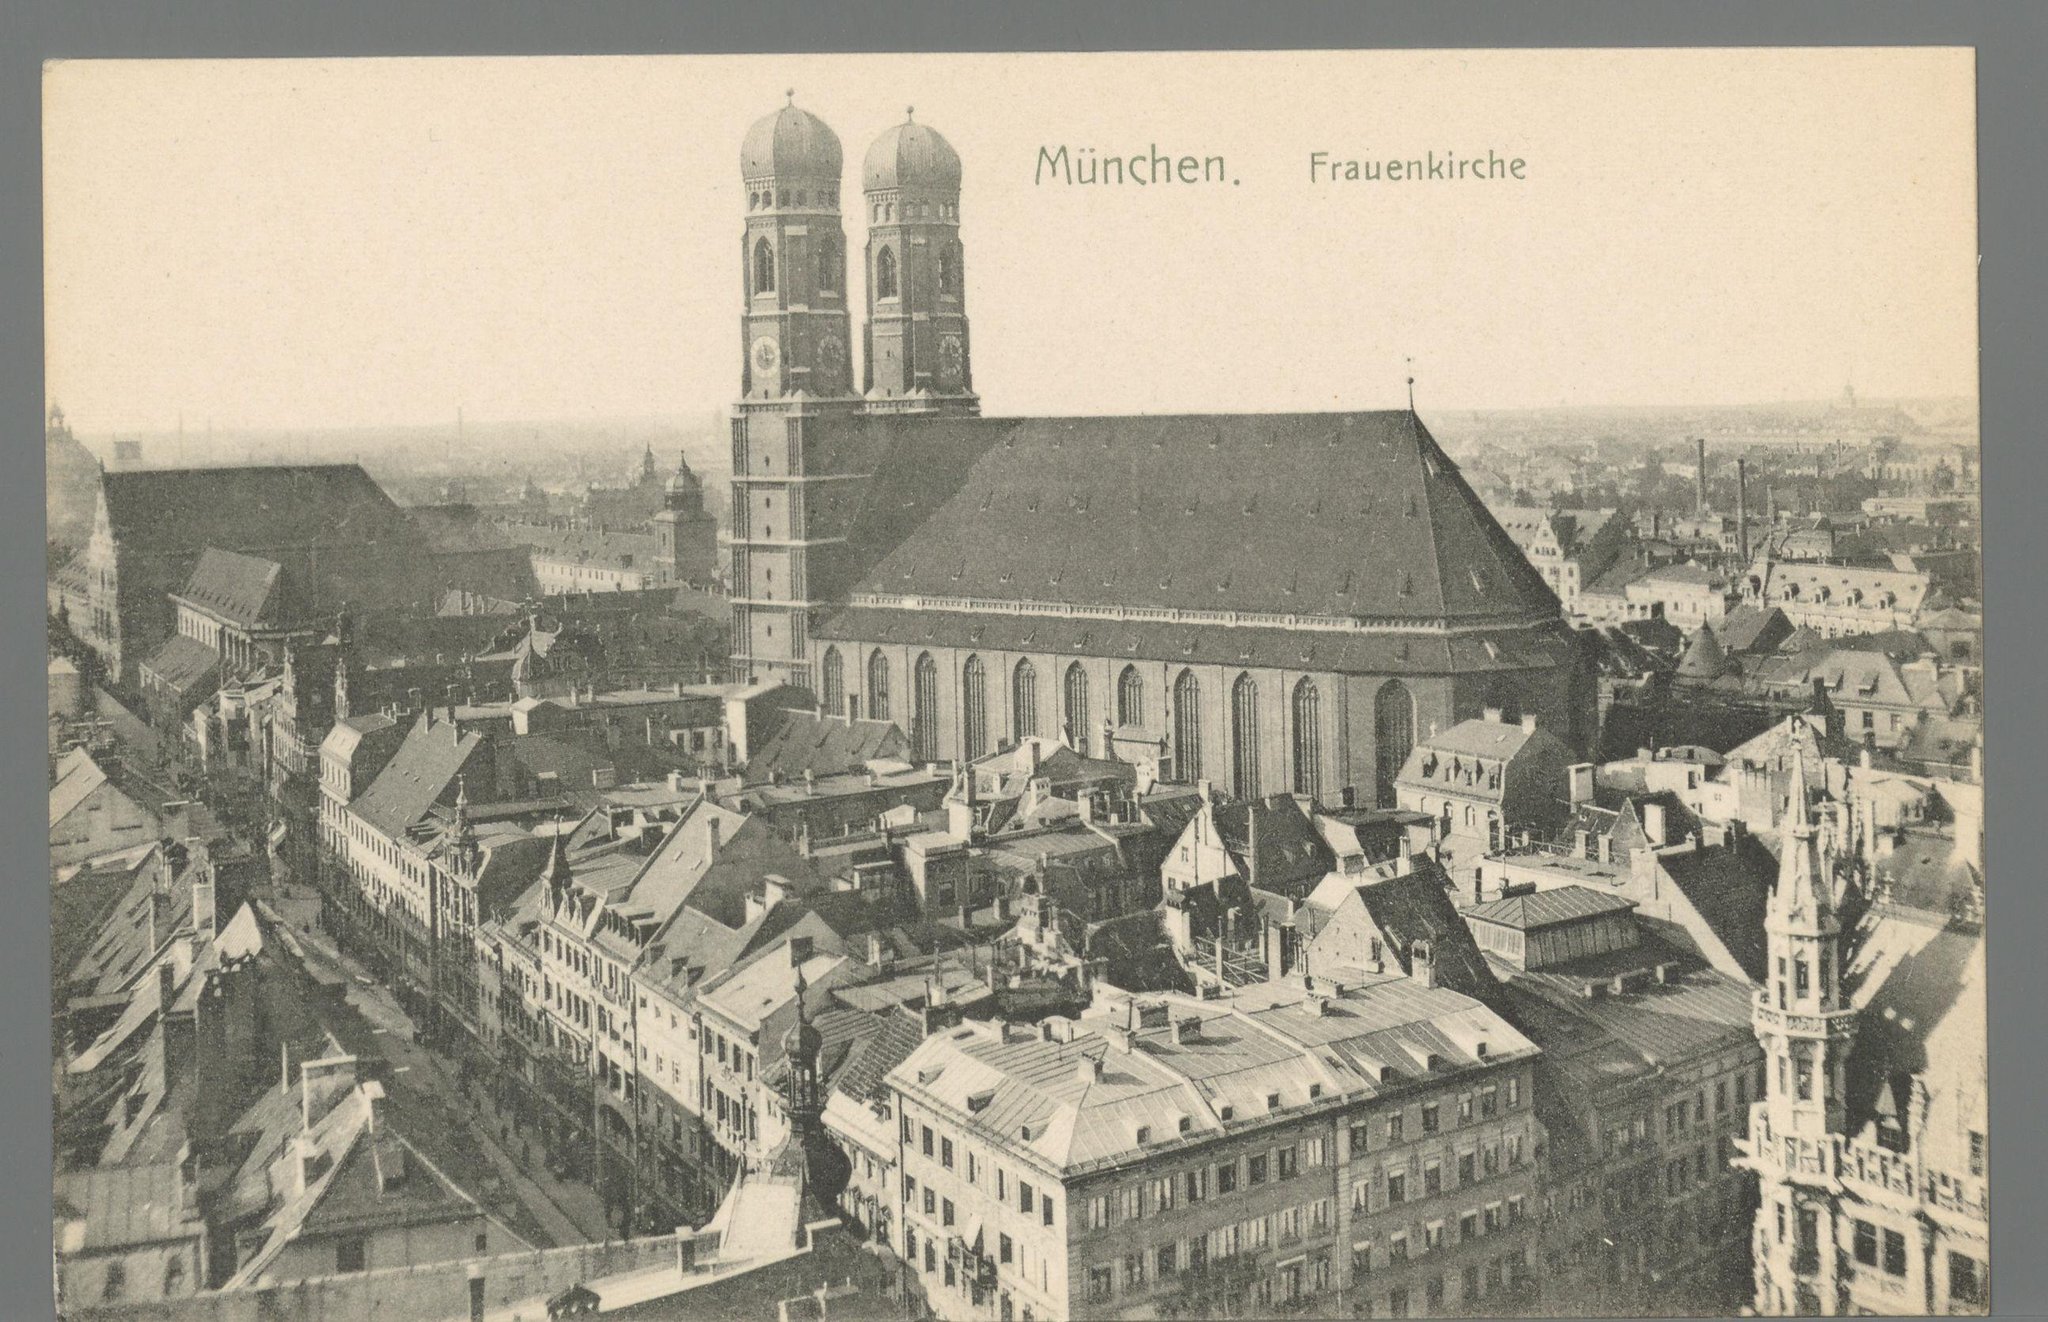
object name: ansichtkaart, prentbriefkaart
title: München. Frauenkirche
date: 1905-1930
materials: cardboard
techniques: photograph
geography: munich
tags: city-view, and landscape with man-made constructions, church (exterior)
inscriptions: inscription: ‘W.H.D.’